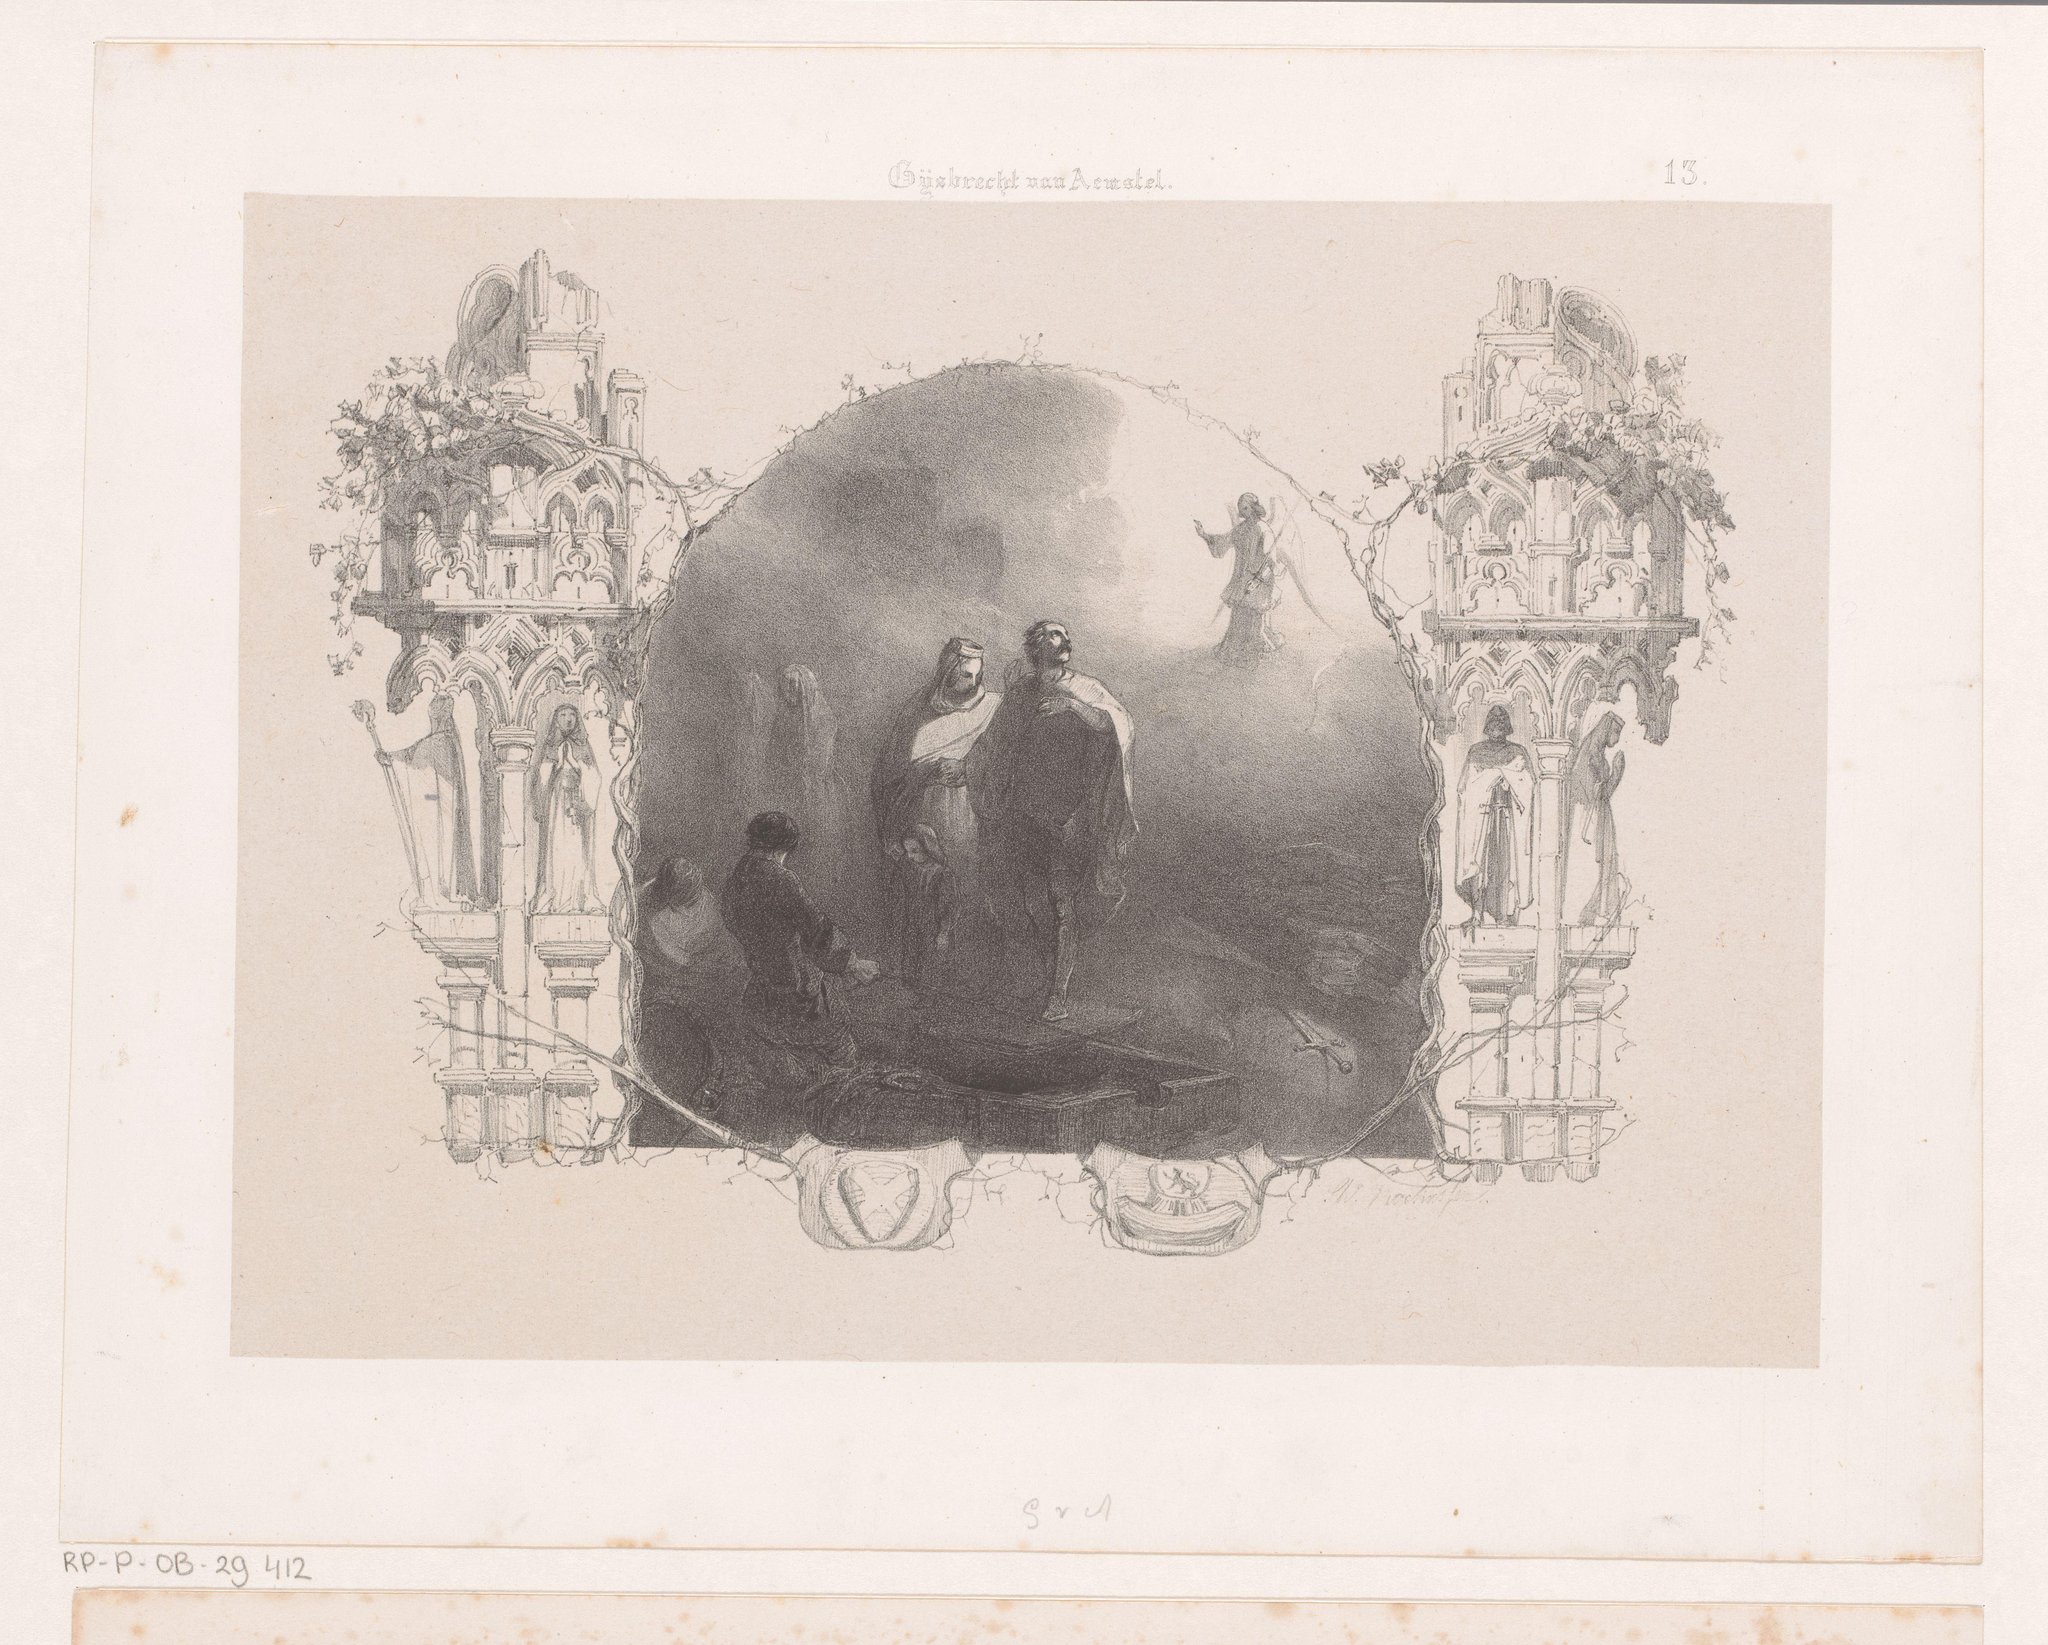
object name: print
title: Engel verschijnt aan een man en vrouw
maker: charles rochussen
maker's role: draughtsman, painter, print maker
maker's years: 1814-1894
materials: paper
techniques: lithograph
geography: the hague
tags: appearances, angels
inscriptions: collector's mark: Lugt 2228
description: Prent uit: Vondel, Joost van den. Gysbrecht van Aemstel, treurspel. Den Haag: Nederlandsche Maatschappij van Schoone Kunsten, 1841.